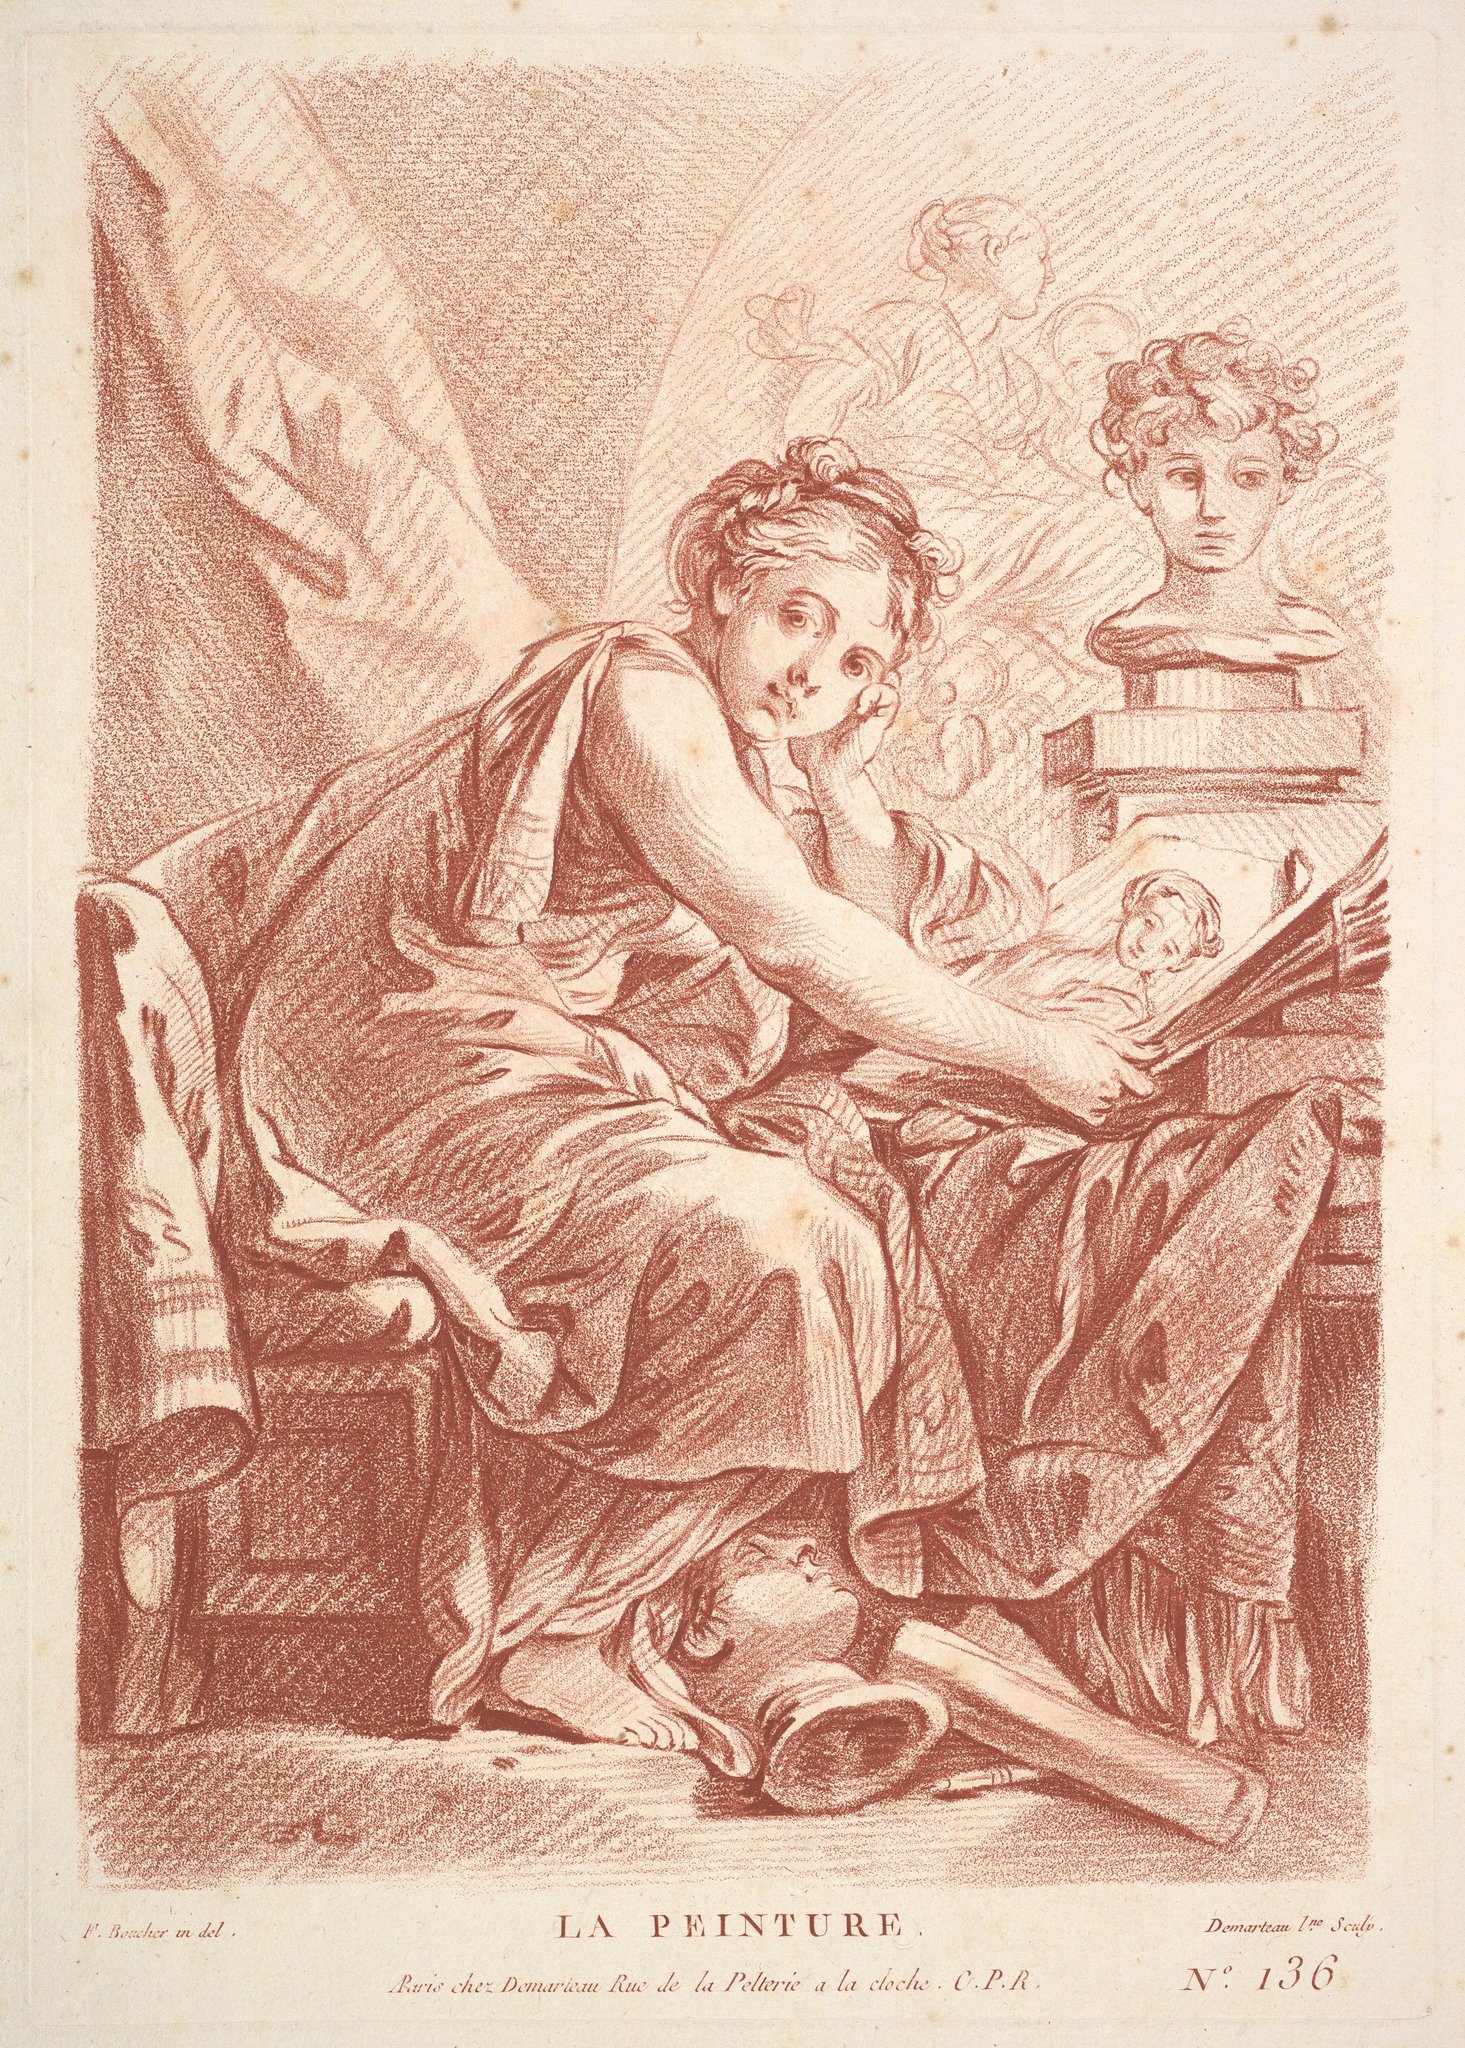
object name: print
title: Painting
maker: gilles demarteau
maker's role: artist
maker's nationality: french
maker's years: 1722-1776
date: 1722-1776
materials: chalk, ink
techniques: engraving, etching, printing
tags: boys,women